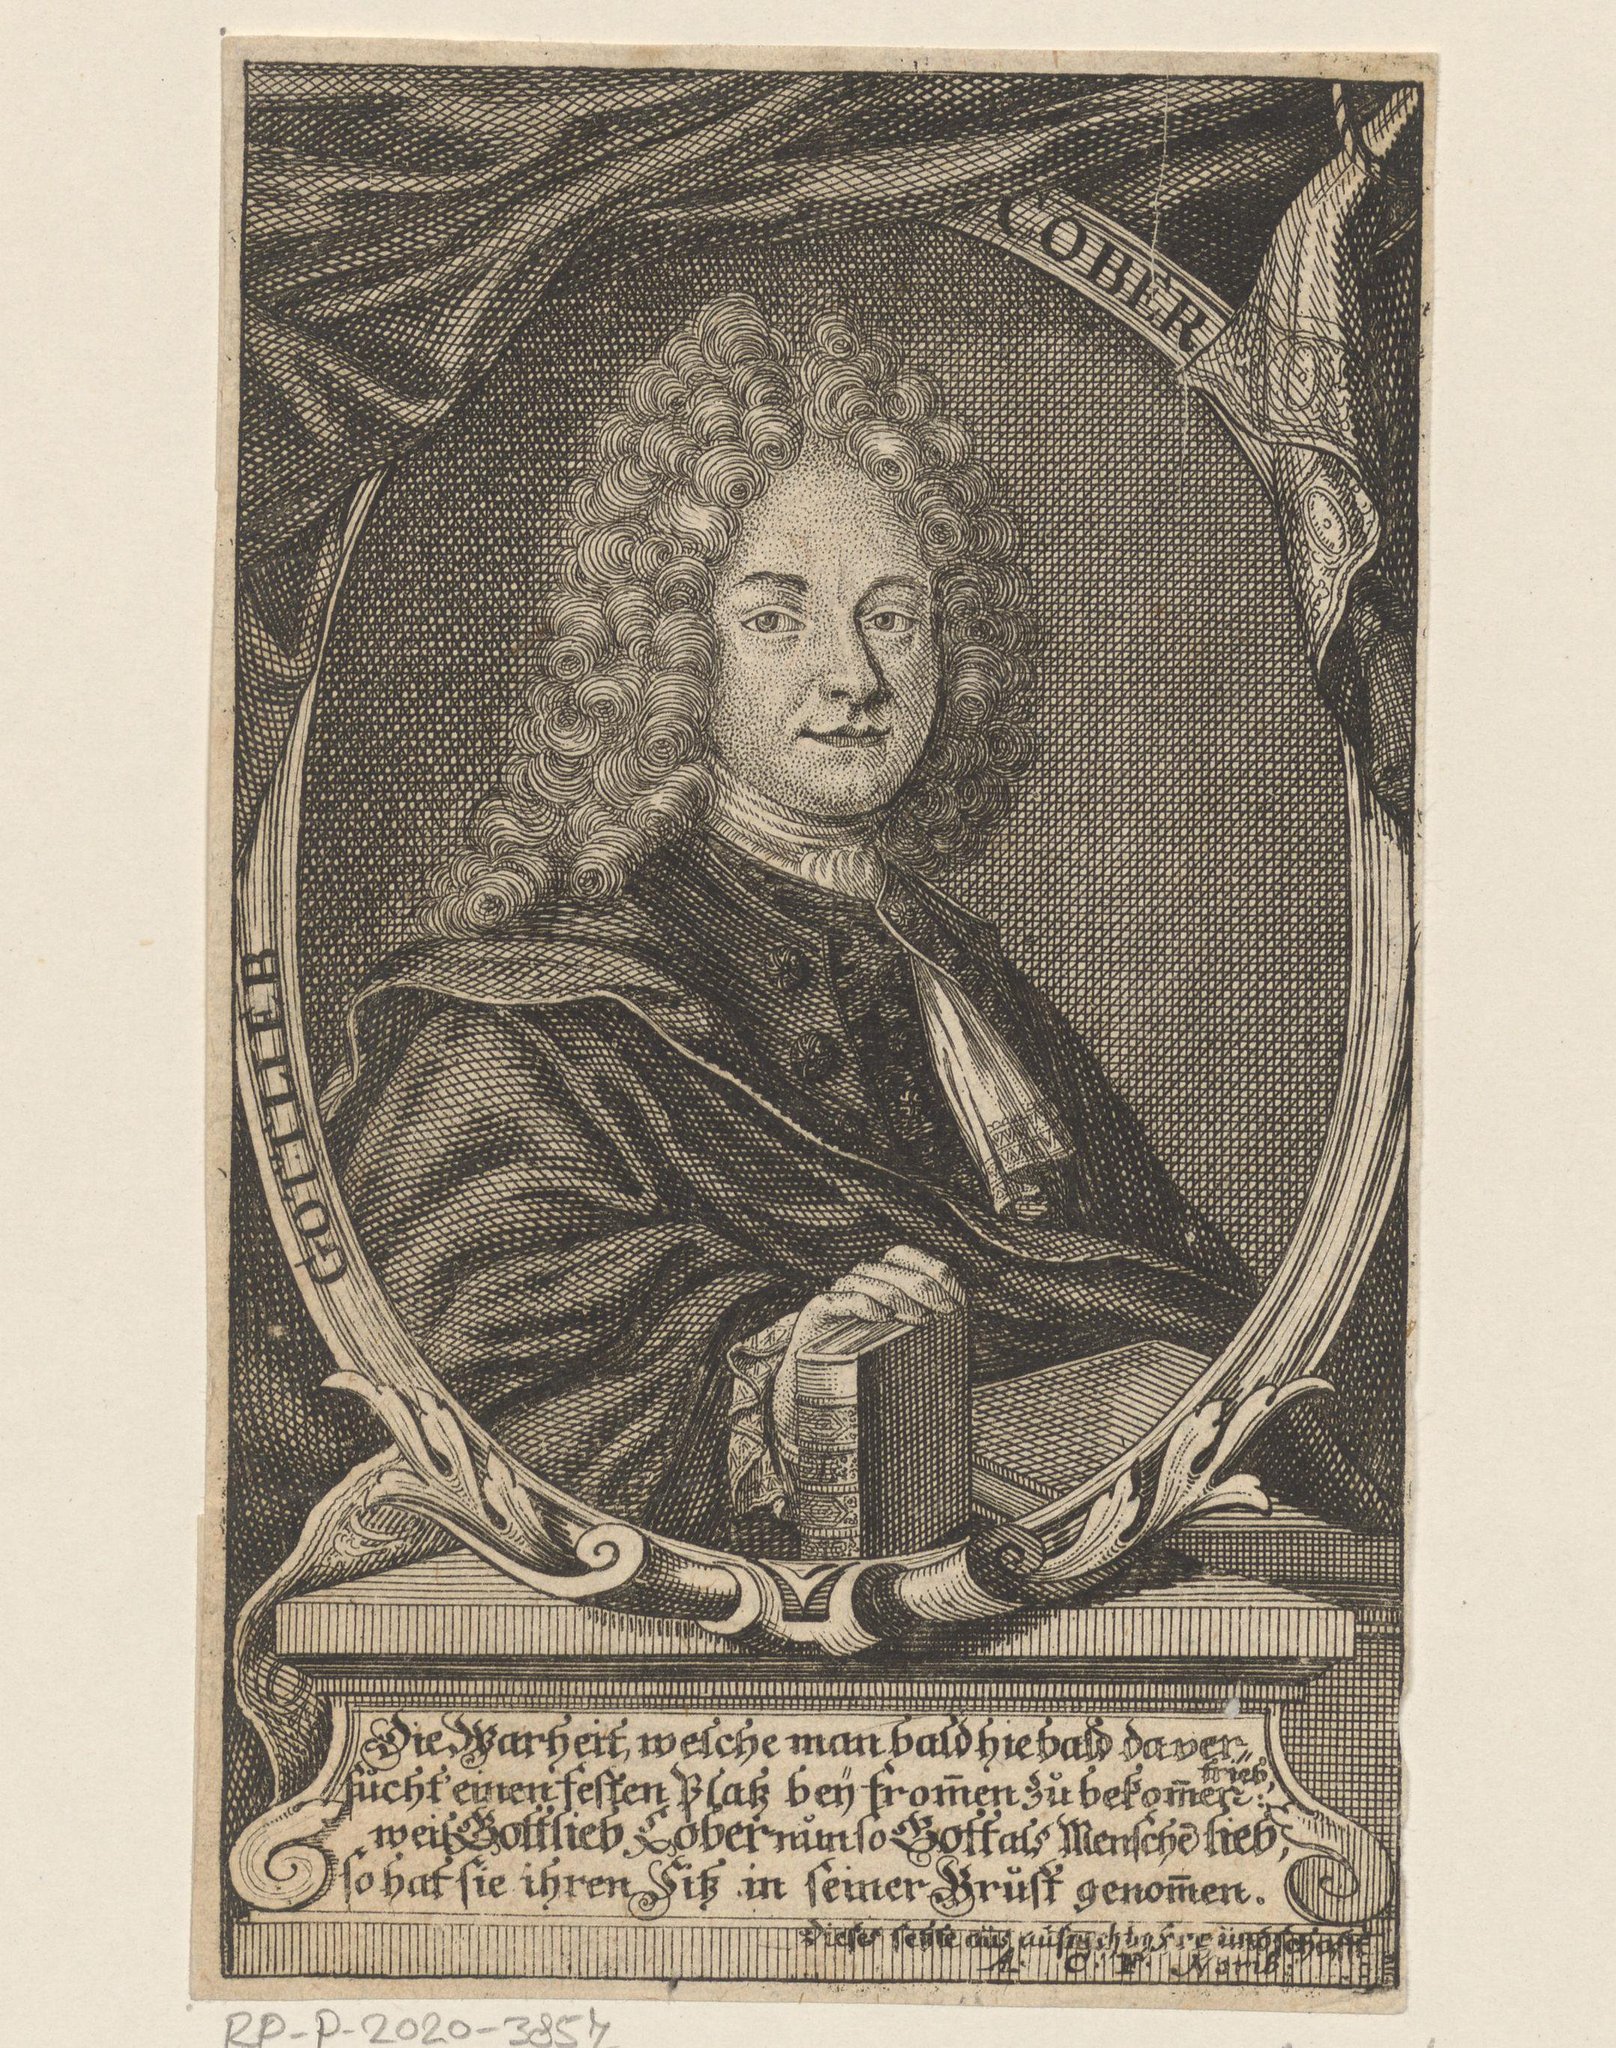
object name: print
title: Portret van Gottlieb Cober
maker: august christian fleischmann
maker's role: print maker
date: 1704-1732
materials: paper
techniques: engraving, etching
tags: historical persons